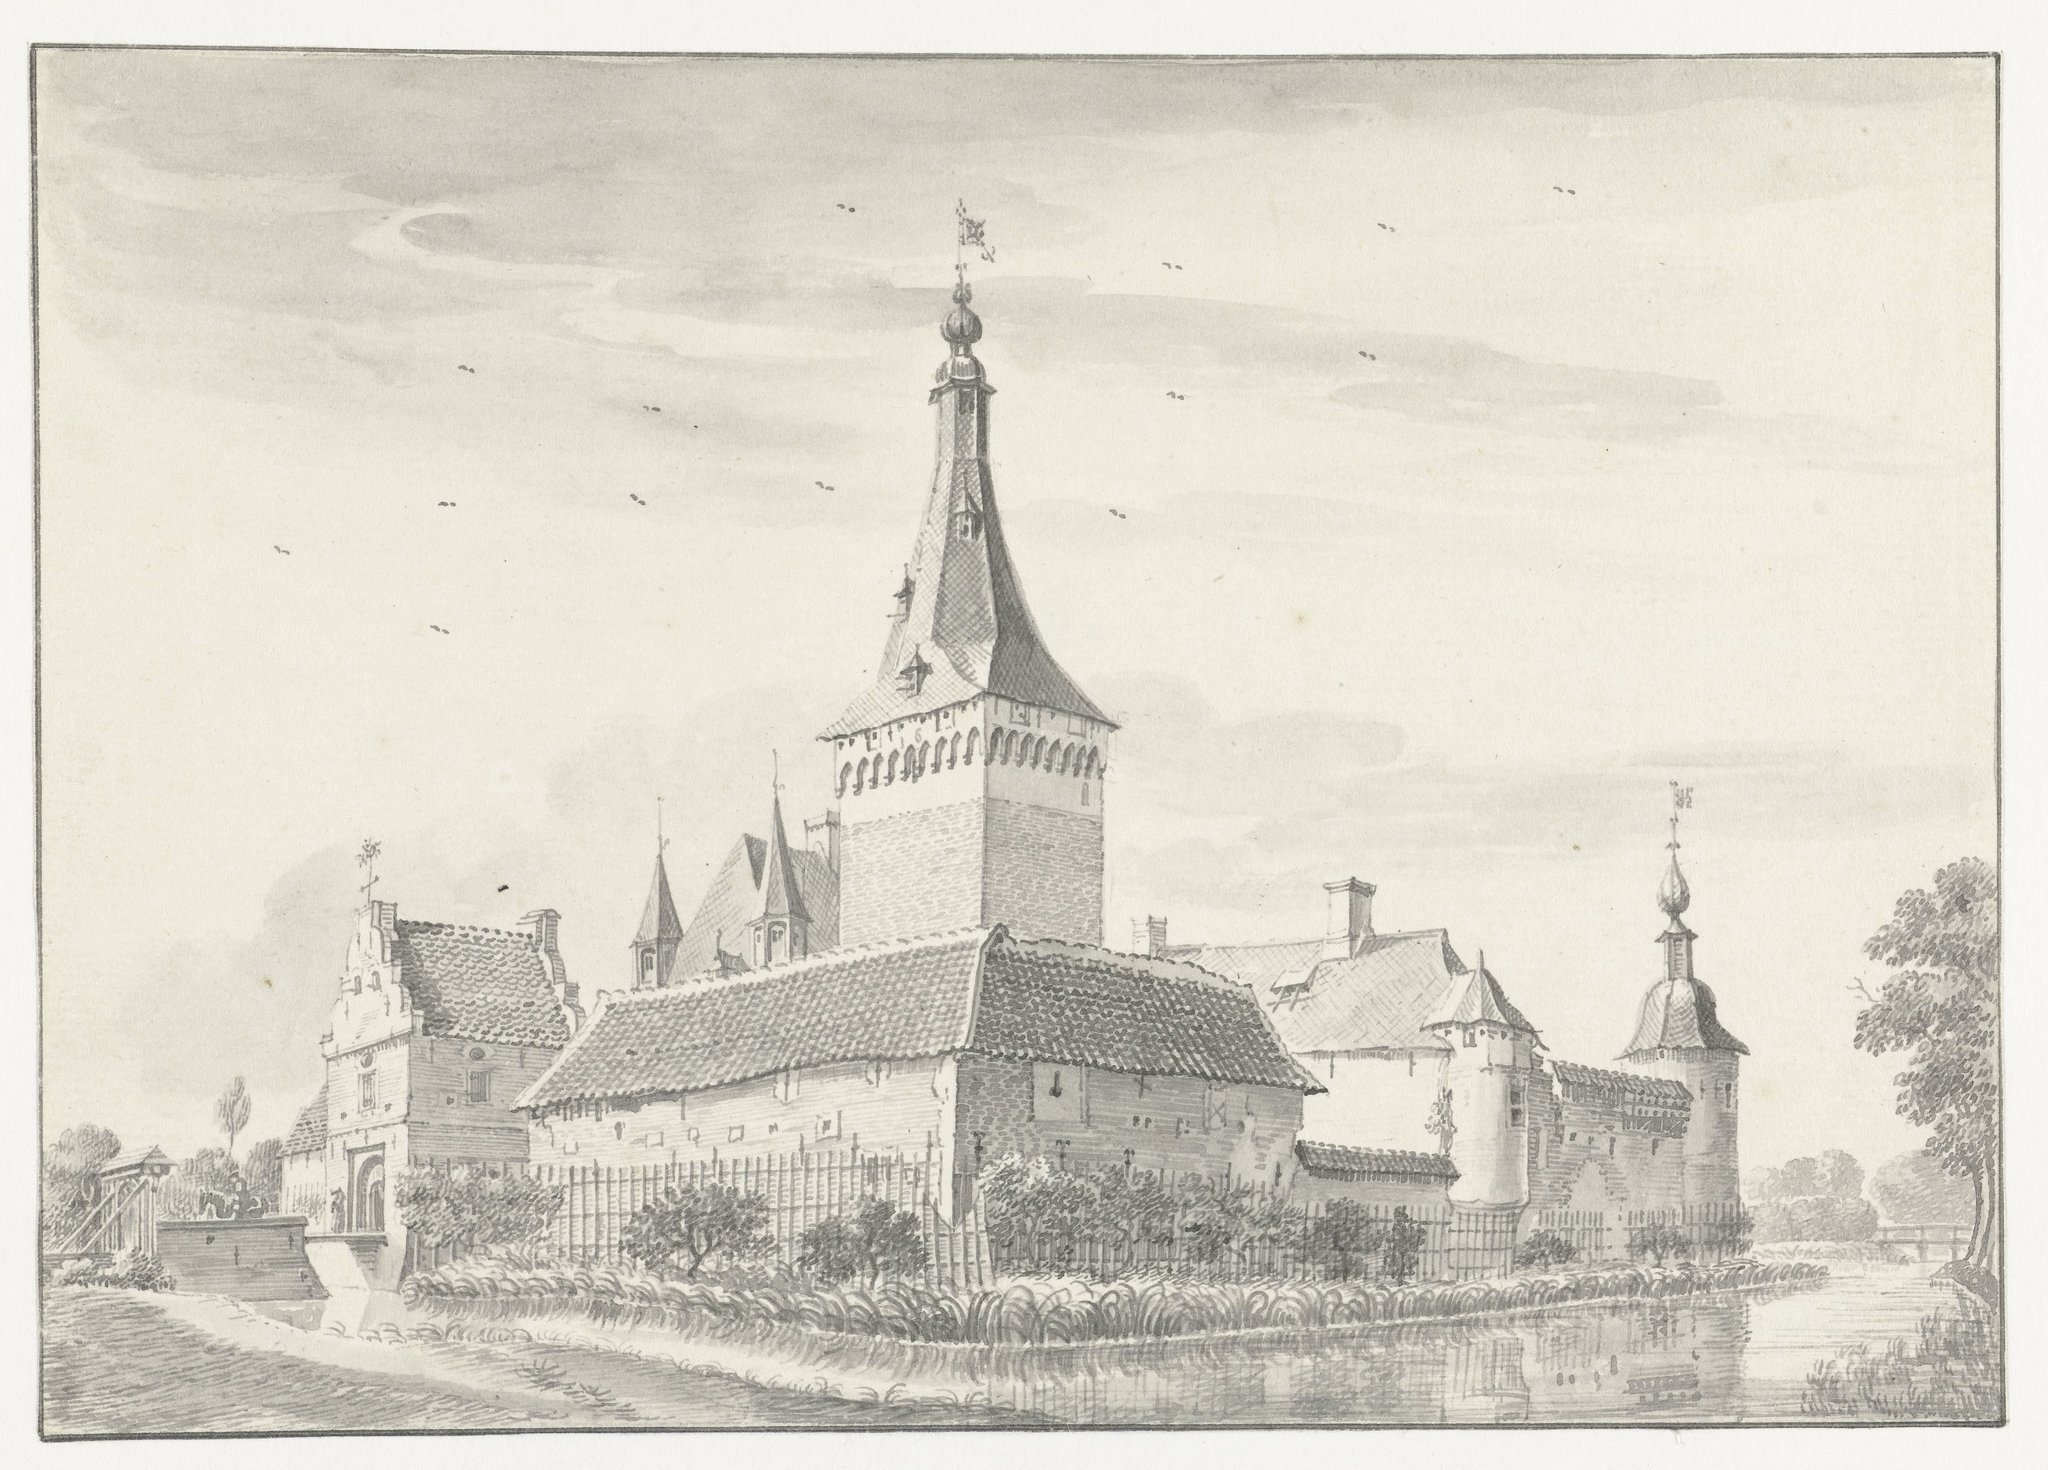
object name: drawing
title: Kasteel Kervendonck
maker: jan de beijer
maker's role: draughtsman, print maker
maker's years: 1703-1780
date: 1743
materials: ink, paper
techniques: brush, pen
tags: castle